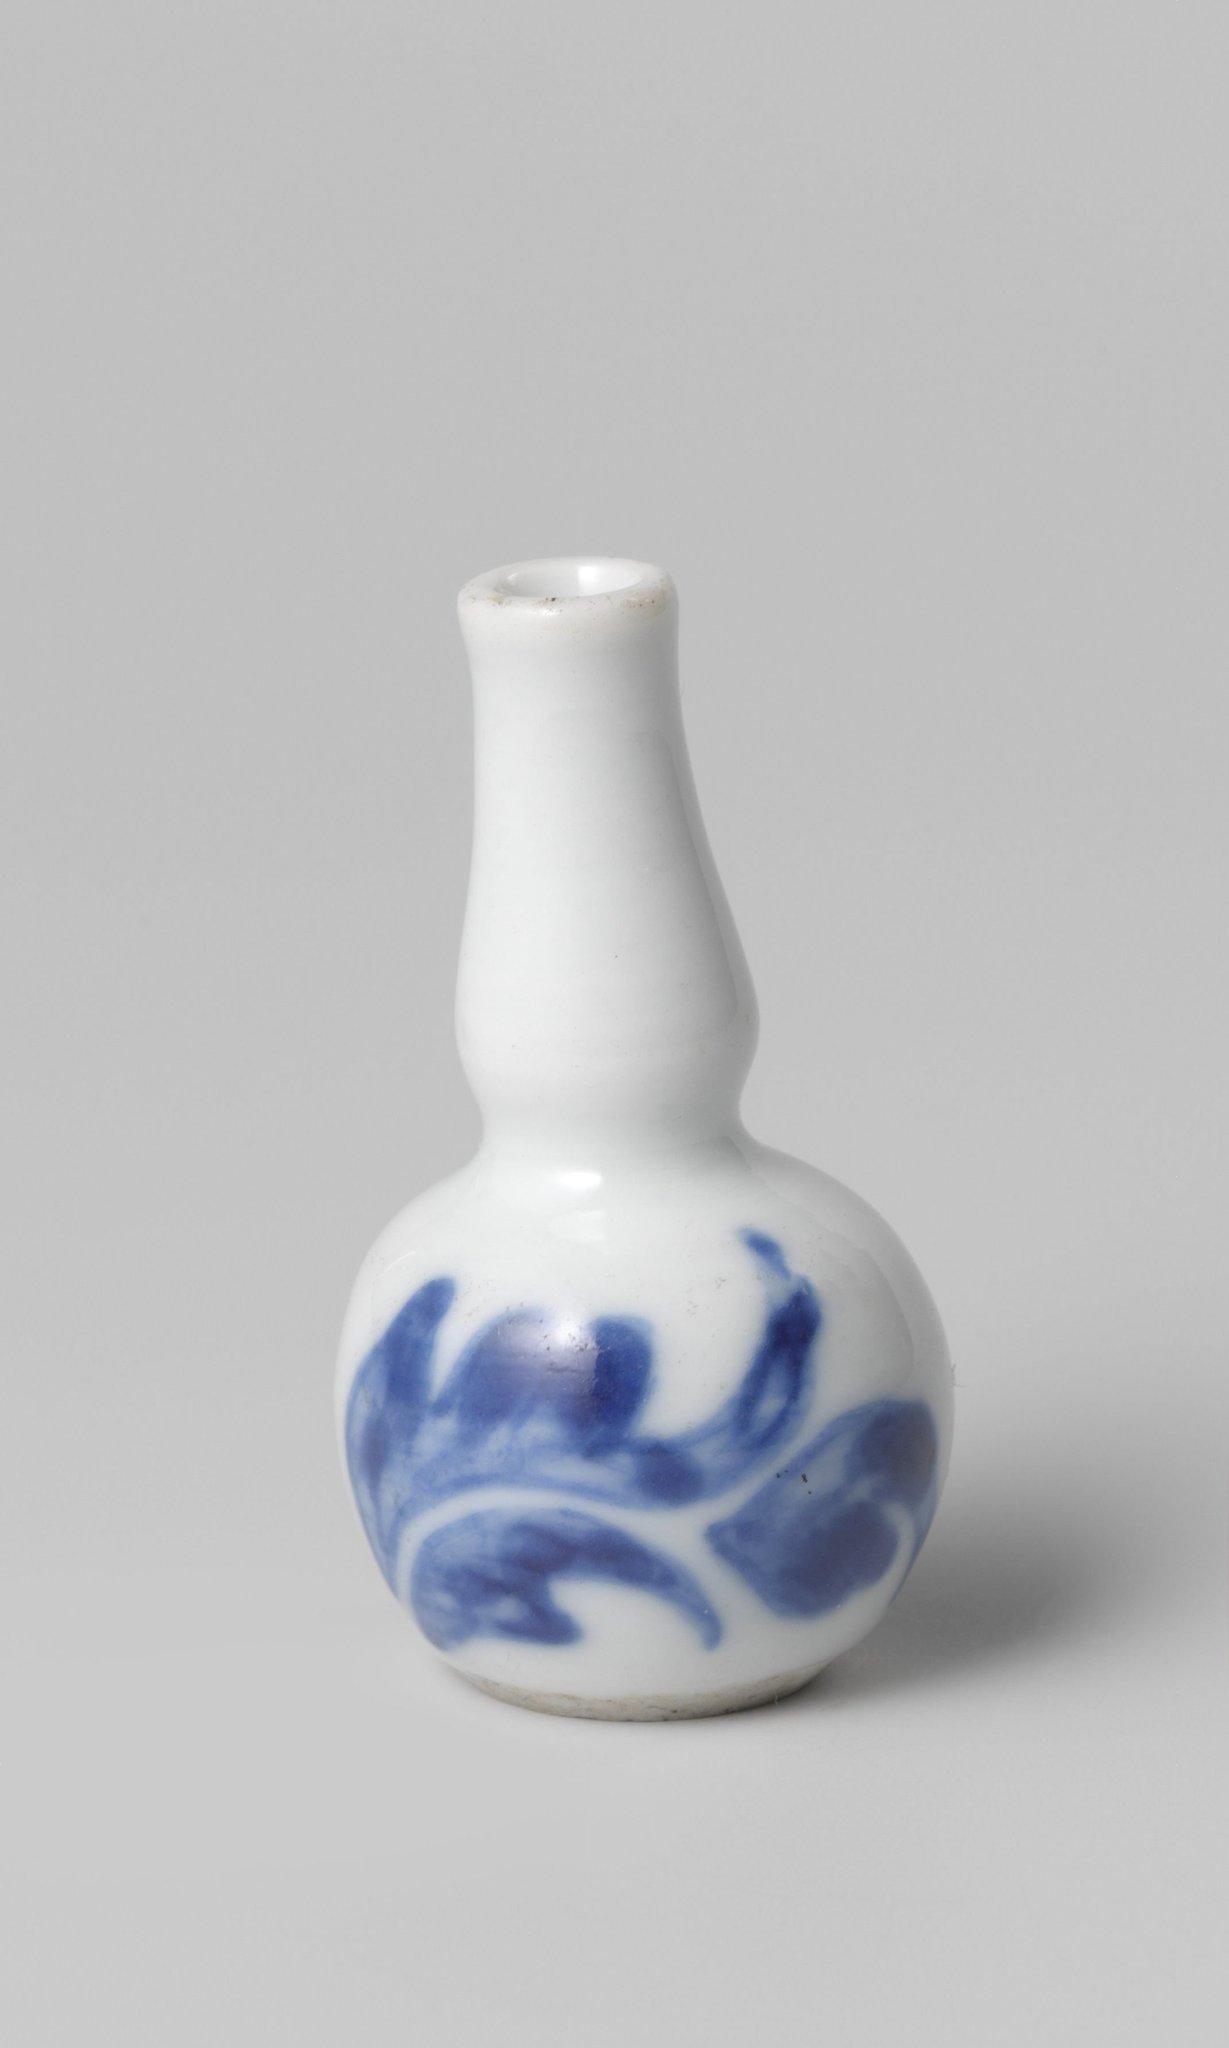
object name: vase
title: Miniature gourd-shaped bottle vase with a flower spray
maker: Anonymous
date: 1675-1724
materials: cobalt, glaze, paint, porcelain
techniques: firing, turning, vitrification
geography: china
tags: ornament derived from plant forms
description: Miniatuur flesvormige vaas van porselein met een kalebasvormig lichaam, beschilderd in onderglazuur blauw. Op de buik een gestileerde bloemtak. Blauw-wit.